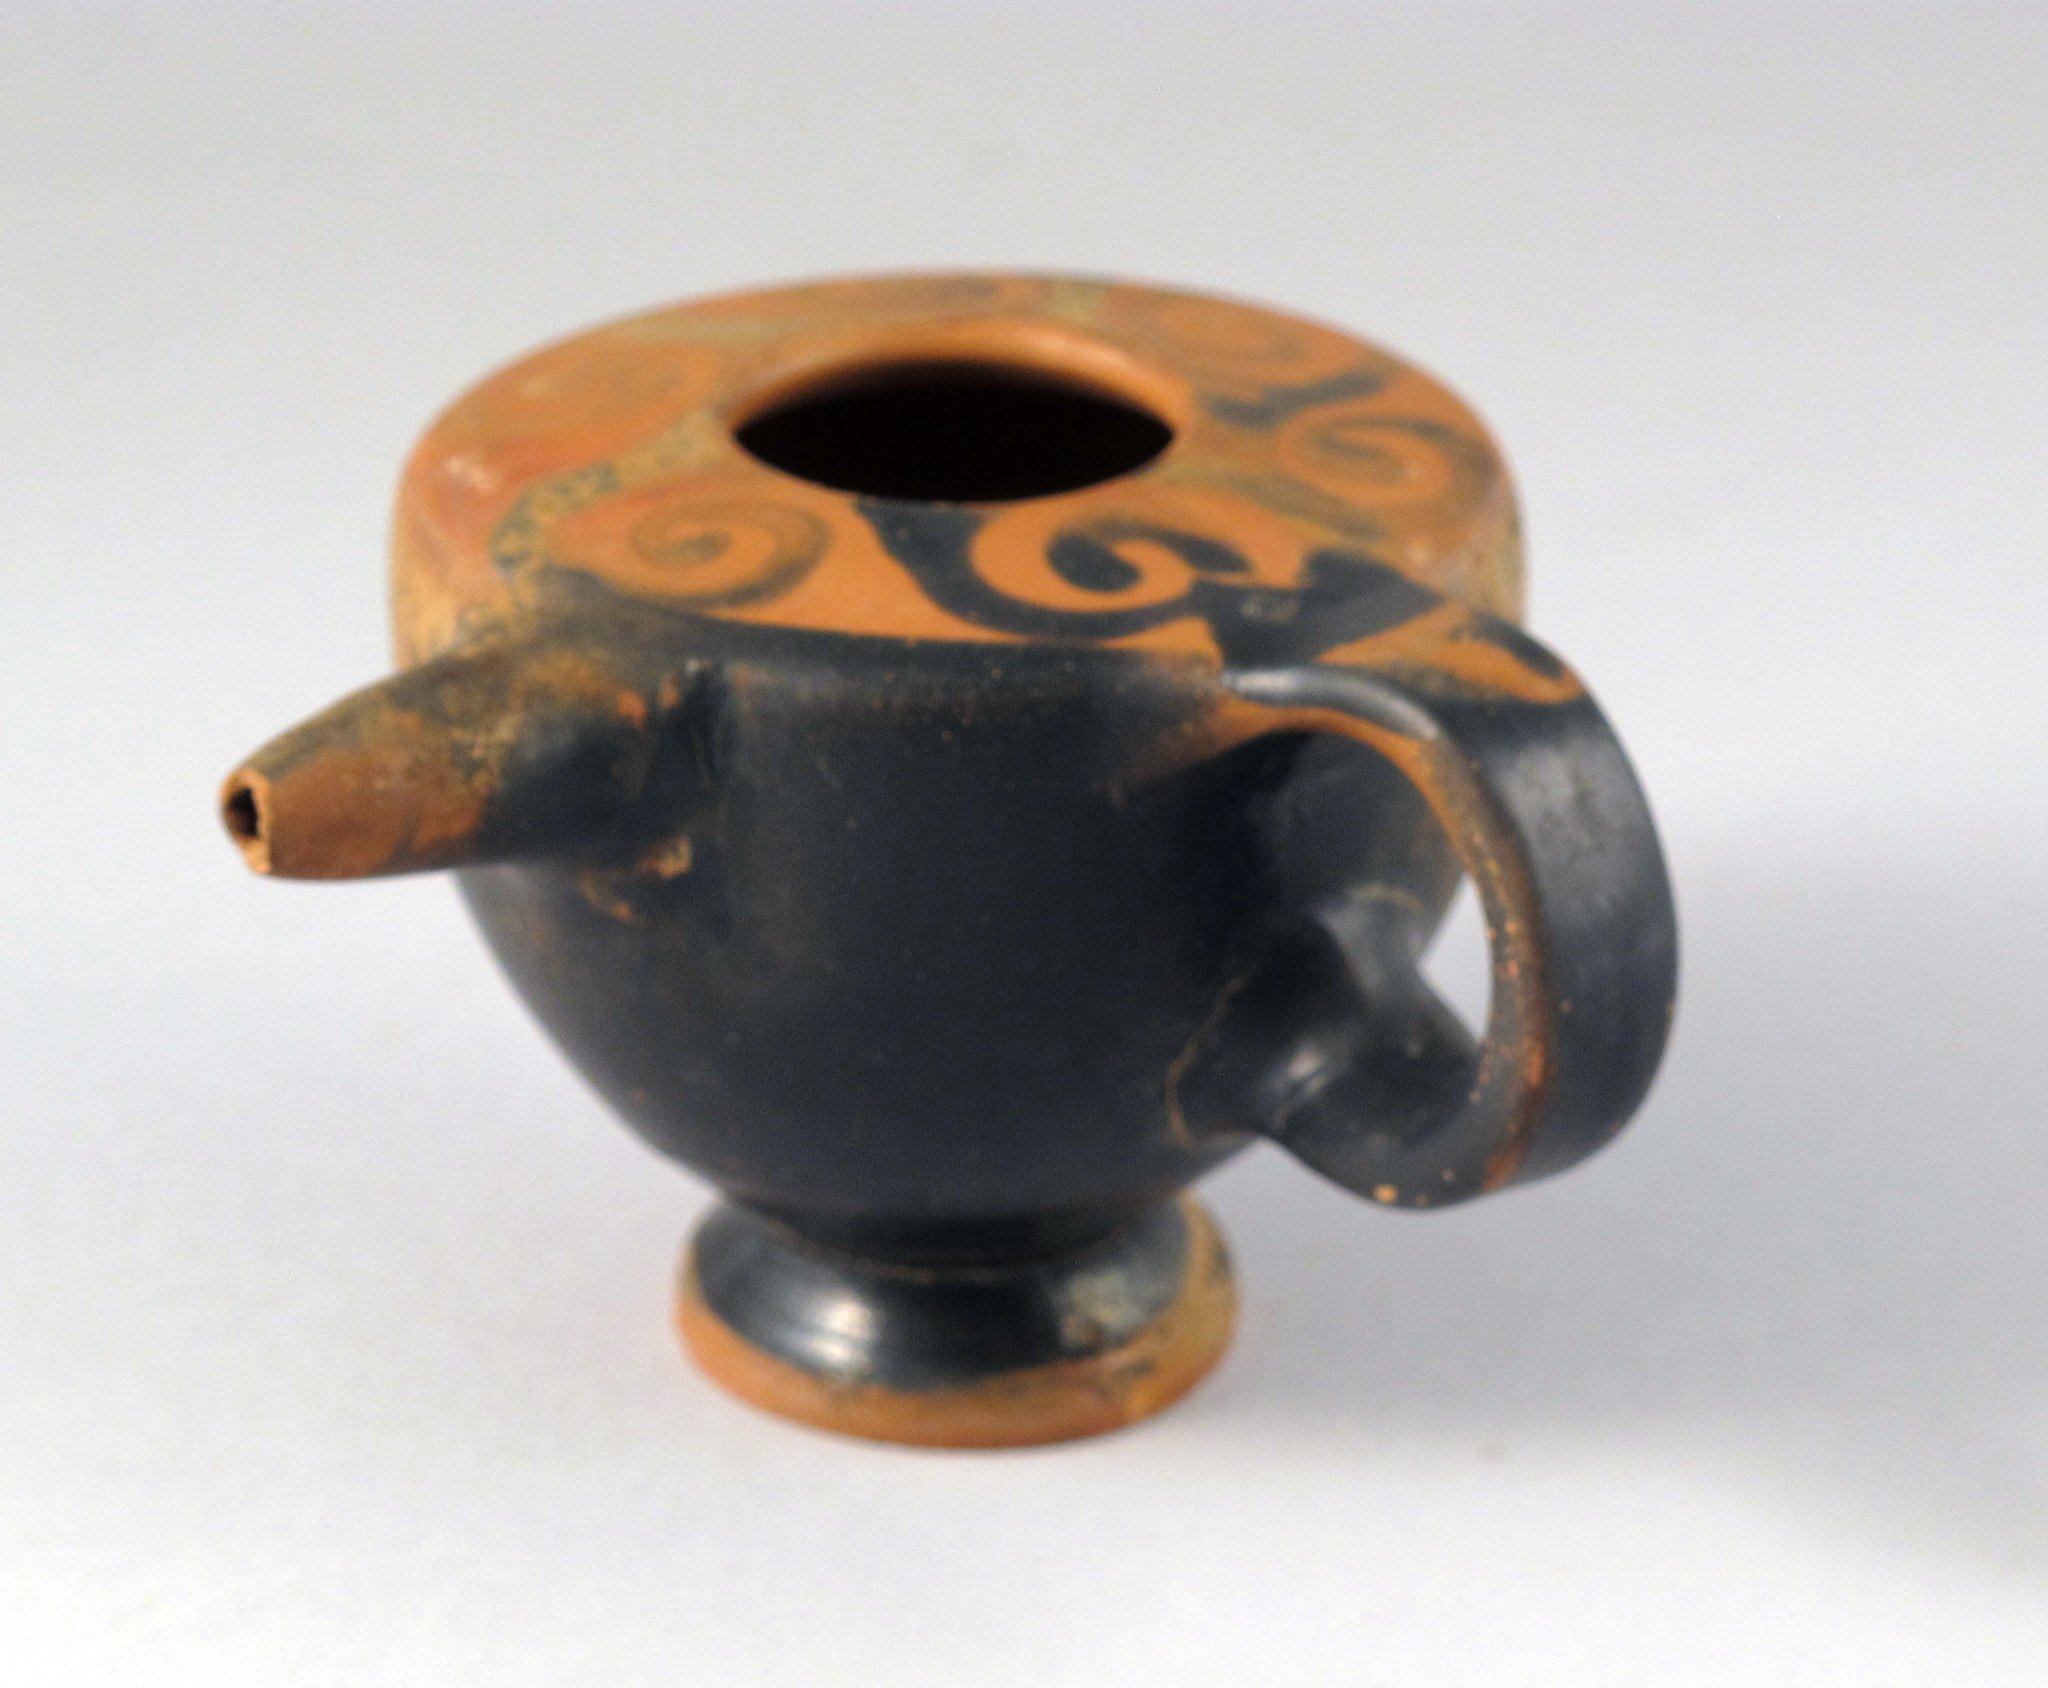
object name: baby feeder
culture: greek, attic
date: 350-325 BCE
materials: terracotta